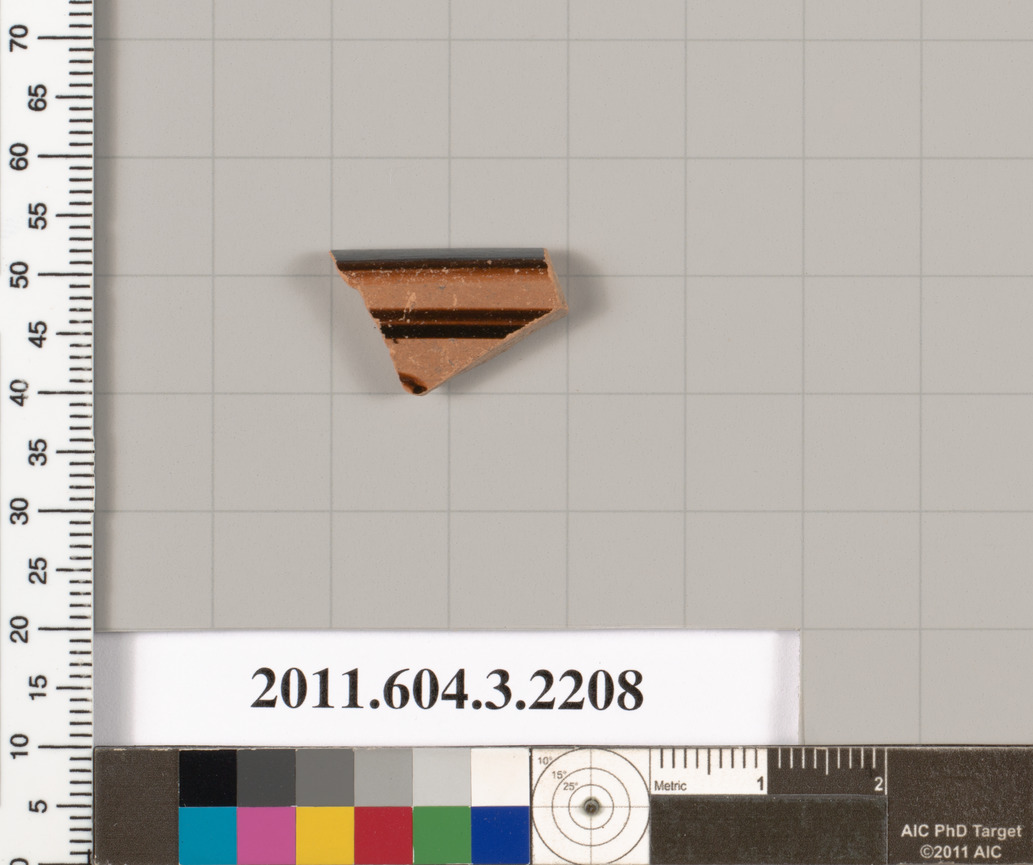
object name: kylix fragment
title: Terracotta fragment of a kylix (drinking cup)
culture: greek, attic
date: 600-401 BCE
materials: terracotta